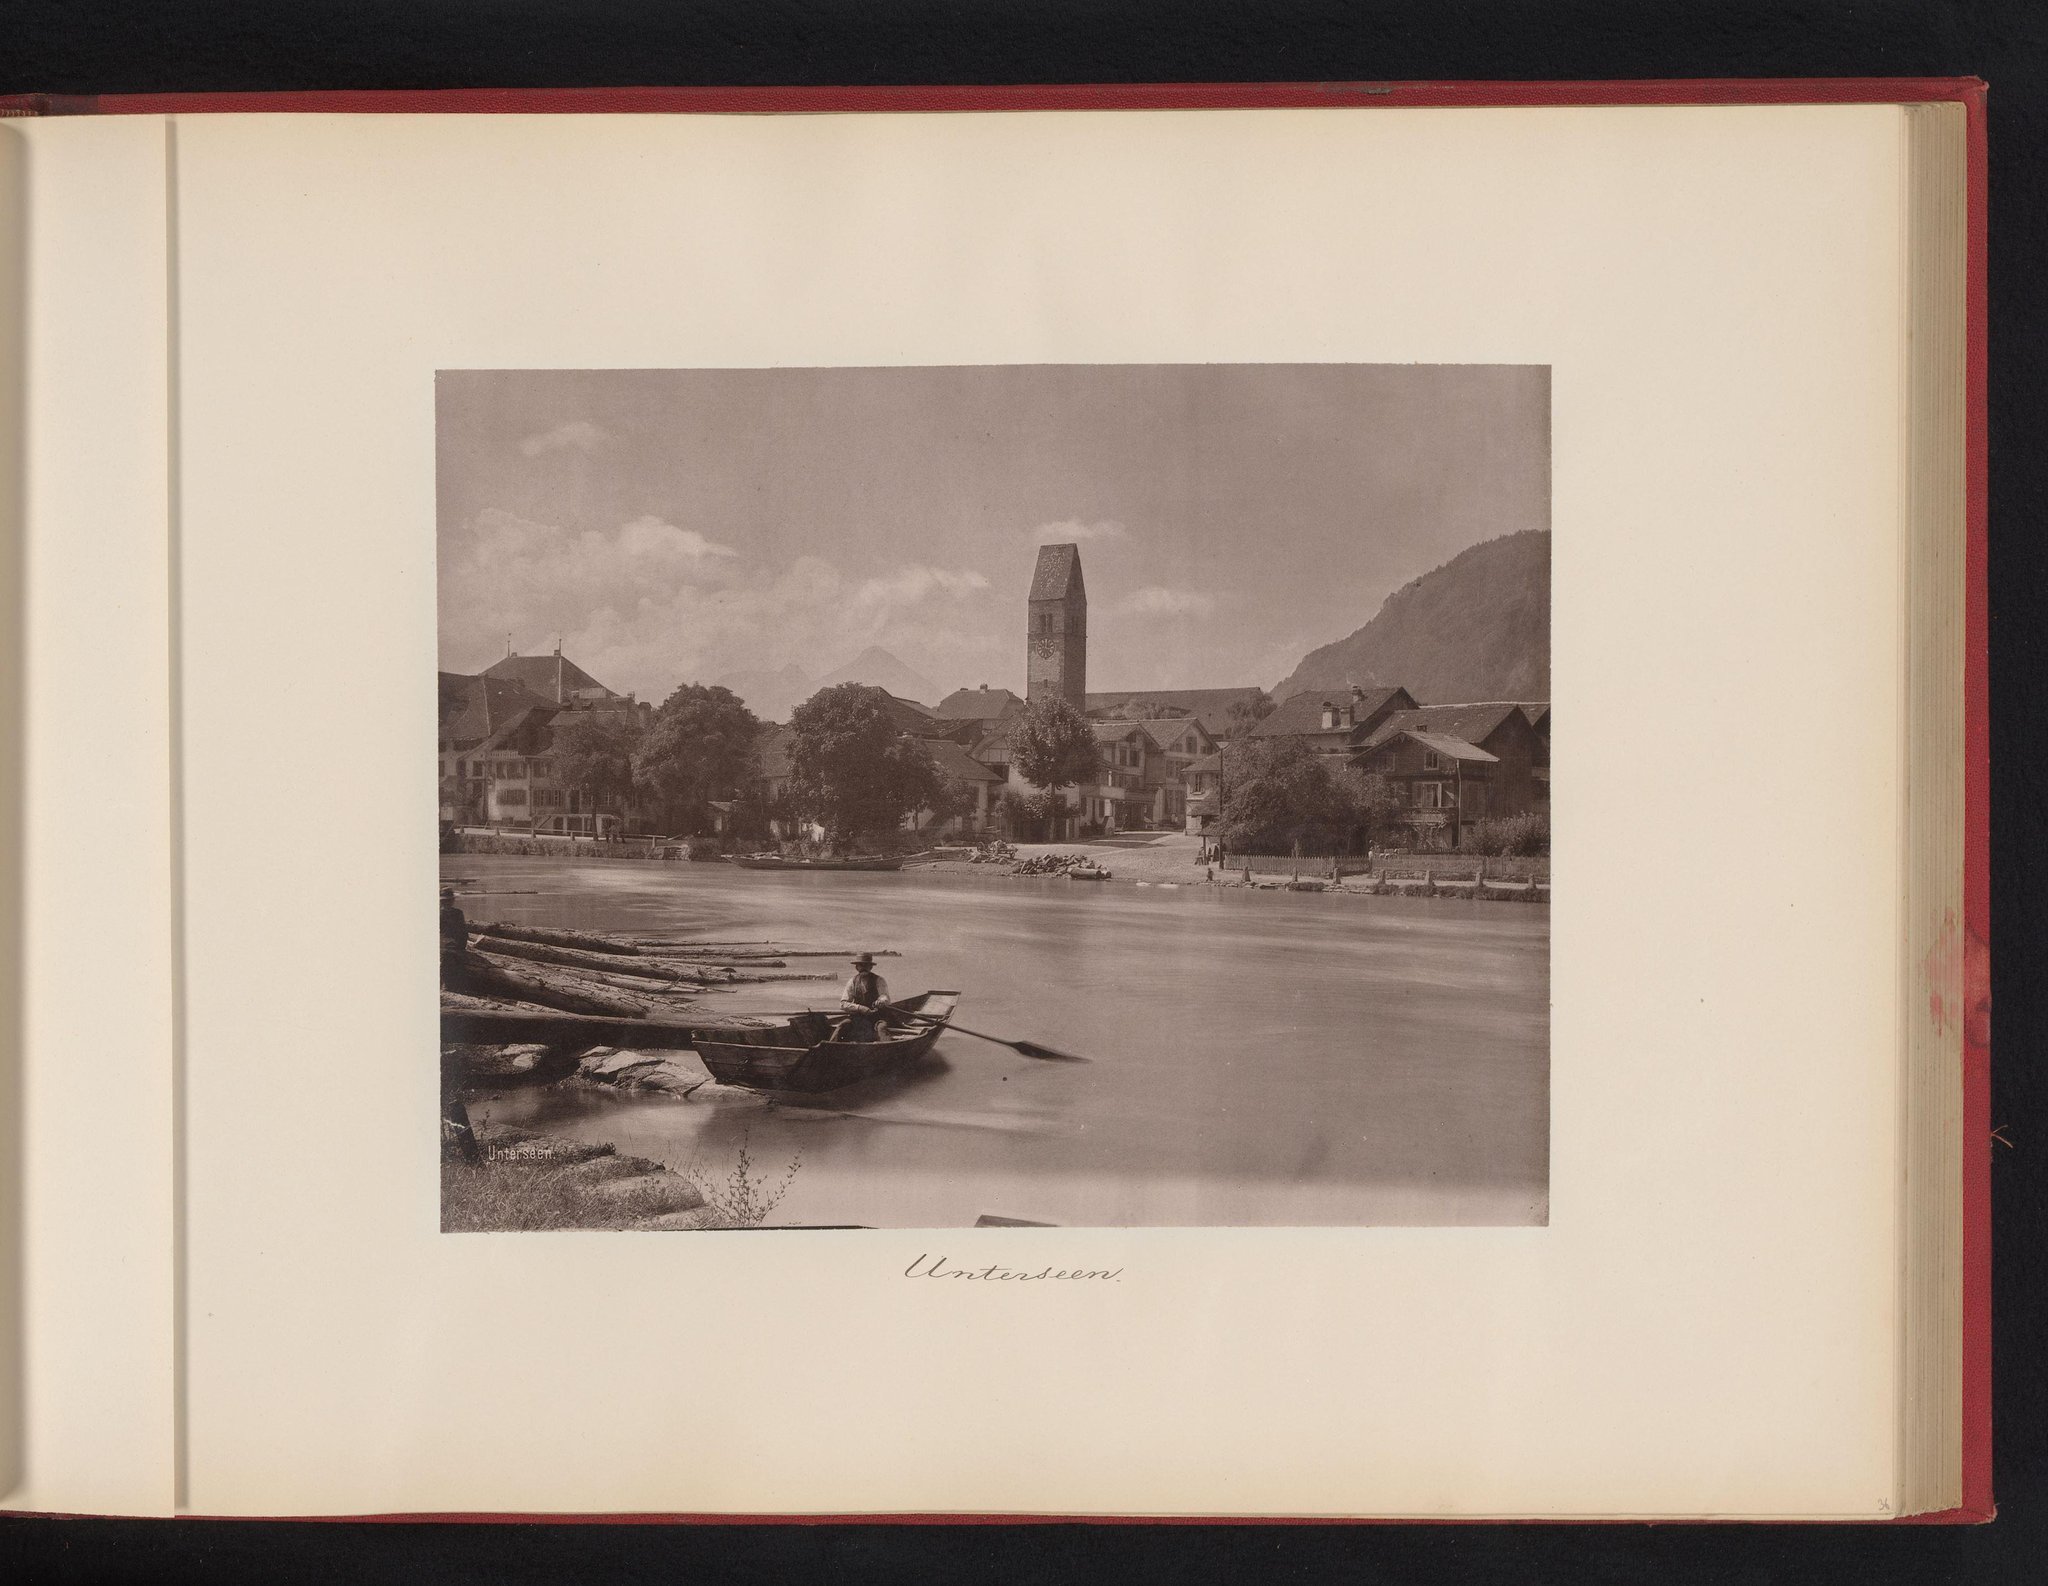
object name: photomechanical print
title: Gezicht op Unterseen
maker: Anonymous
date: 1880-1900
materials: paper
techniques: photograph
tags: city-view in general; 'veduta'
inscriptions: inscription: ‘Unterseen.’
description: Deze prent maakt deel uit van een album.